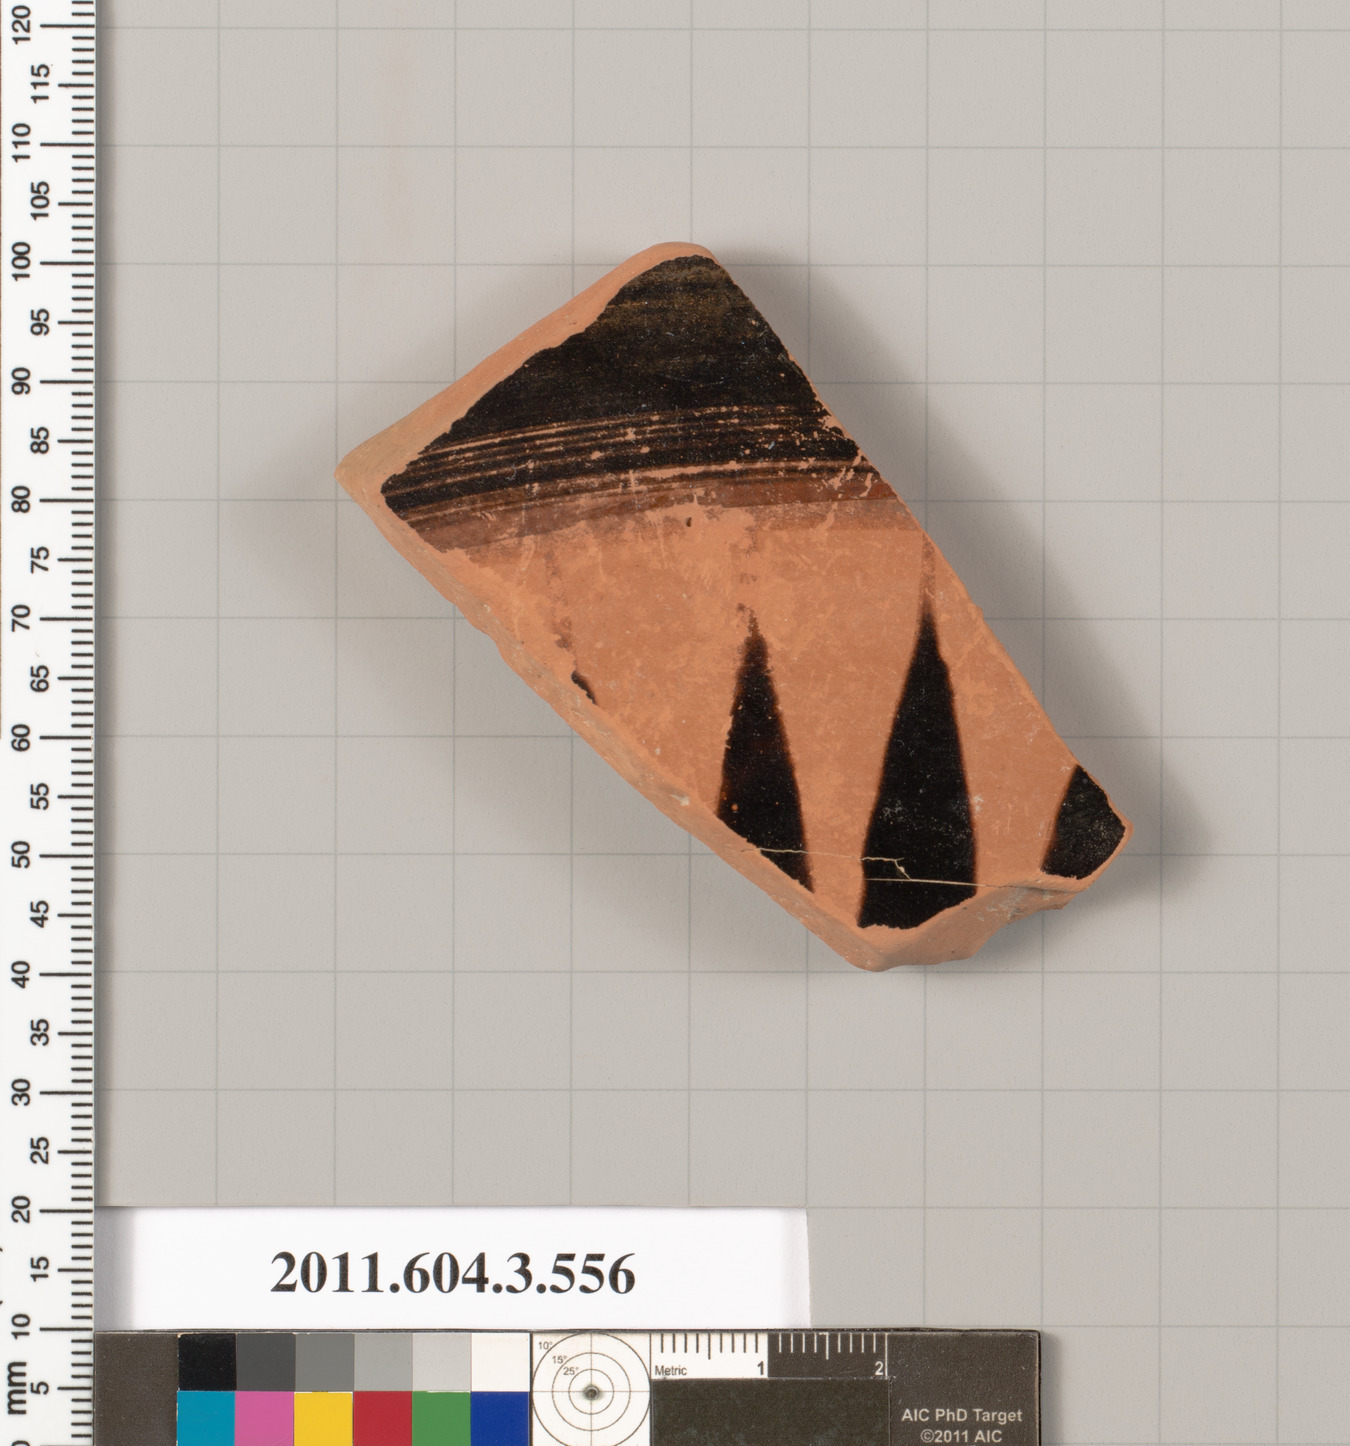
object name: column krater fragment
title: Terracotta fragment of a column-krater (bowl for mixing wine and water)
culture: greek, attic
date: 600-401 BCE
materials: terracotta